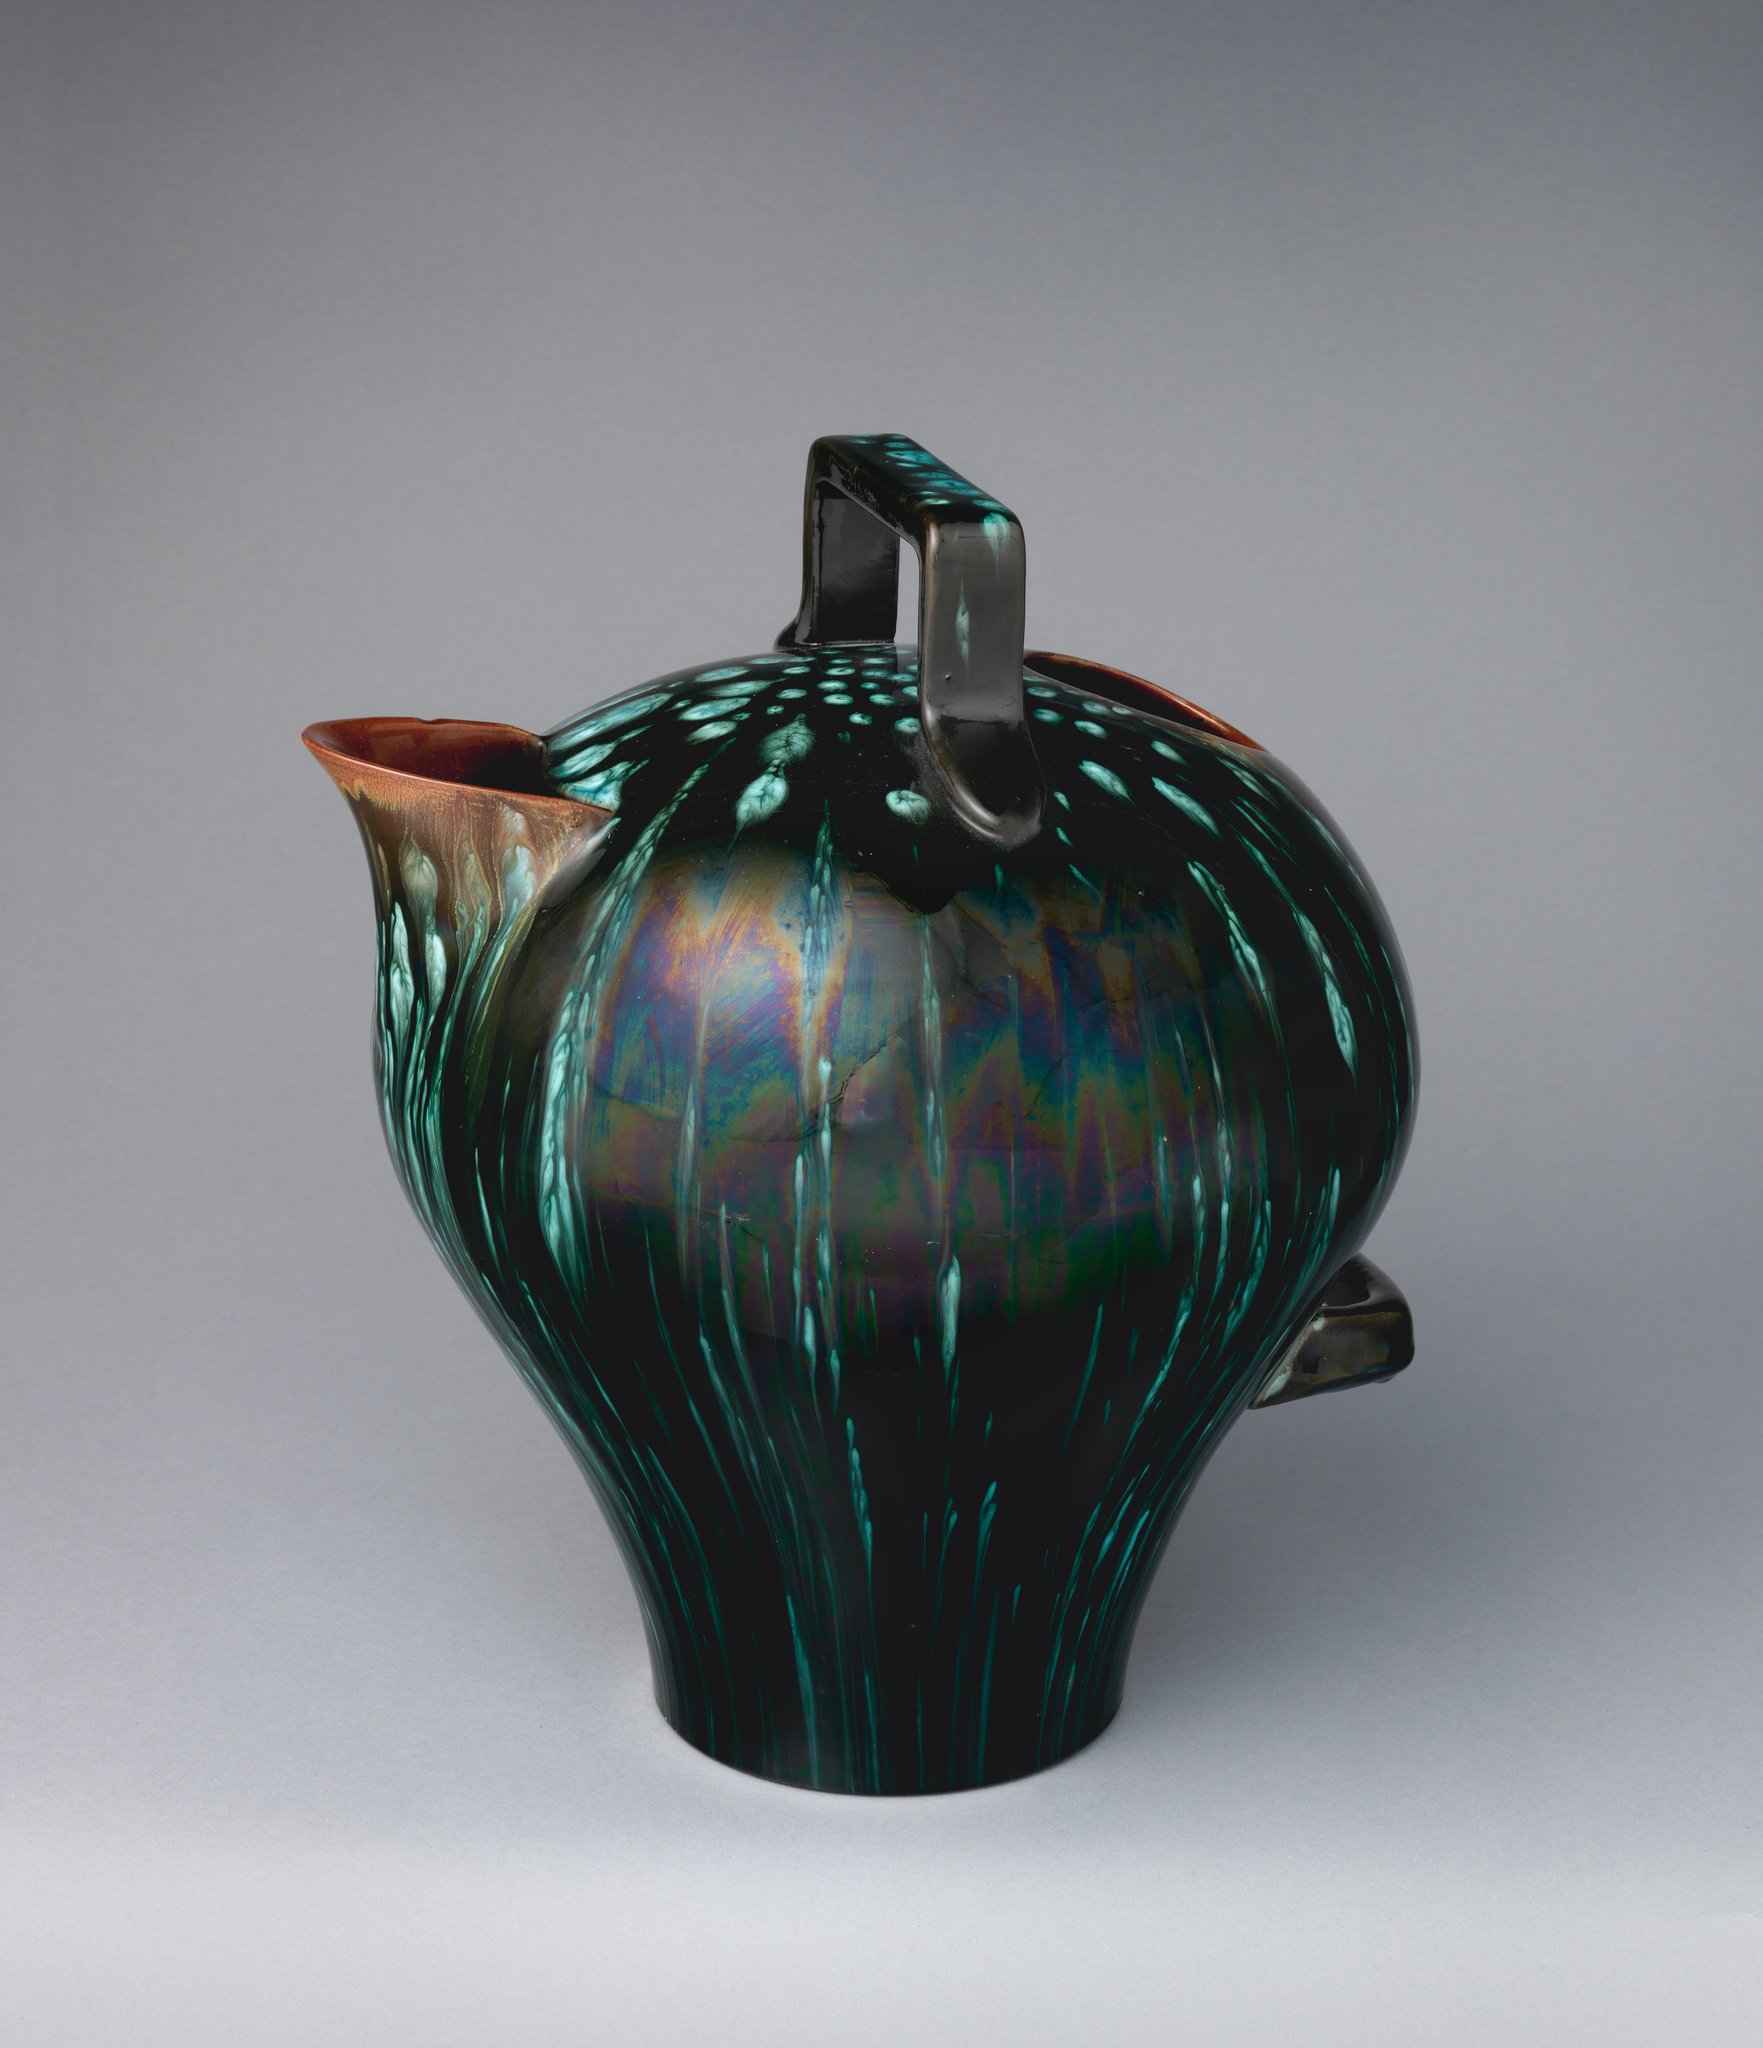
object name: jug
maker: christopher dresser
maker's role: designer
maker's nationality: british, scottish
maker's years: 1834-1904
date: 1880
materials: earthenware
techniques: glazing